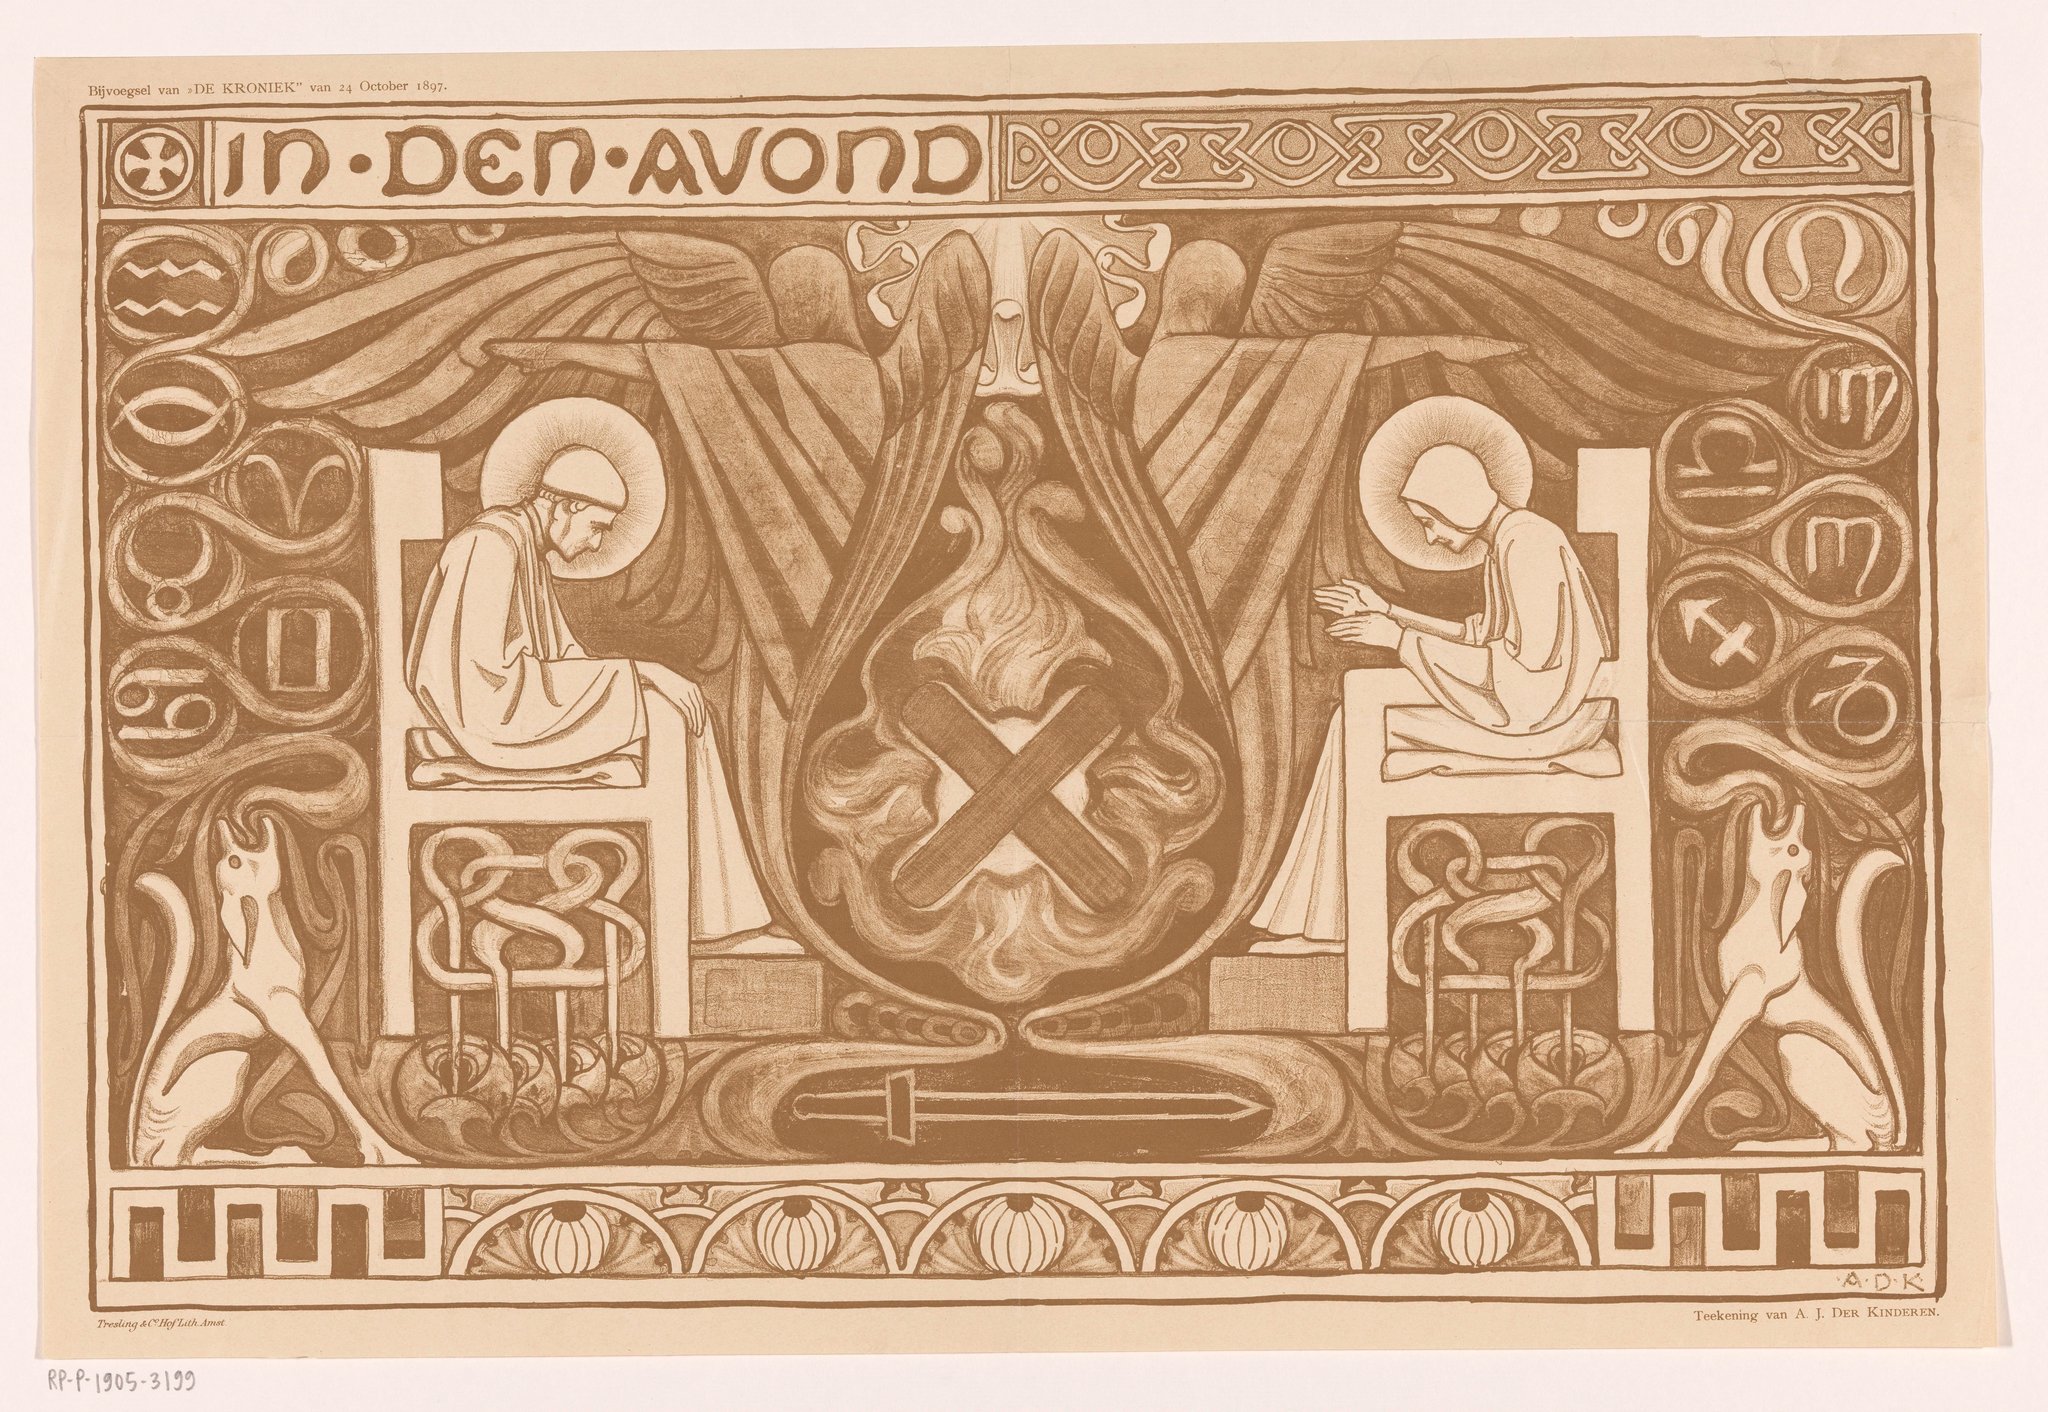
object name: print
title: In den avond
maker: antoon derkinderen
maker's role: draughtsman, painter, print maker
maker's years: 1859-1925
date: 1897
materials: paper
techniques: lithograph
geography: amsterdam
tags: sitting figure, evening, open fire (in general), zodiac; the twelve zodiacal signs together, fabulous beings with wings, hearth and stove, dog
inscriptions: collector's mark: Lugt 2228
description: Een man en vrouw staren in een vuur waarin balken in de vorm van een andreaskruis branden. Onder het vuur een zwaard. Uit het vuur stijgen twee gevleugelde figuren op die hun arm uitstrekken boven het hoofd van de man en vrouw. Uiterst links en uiterst rechts produceren twee honden golvende klanklijnen met daarin tekens uit de dierenriem.